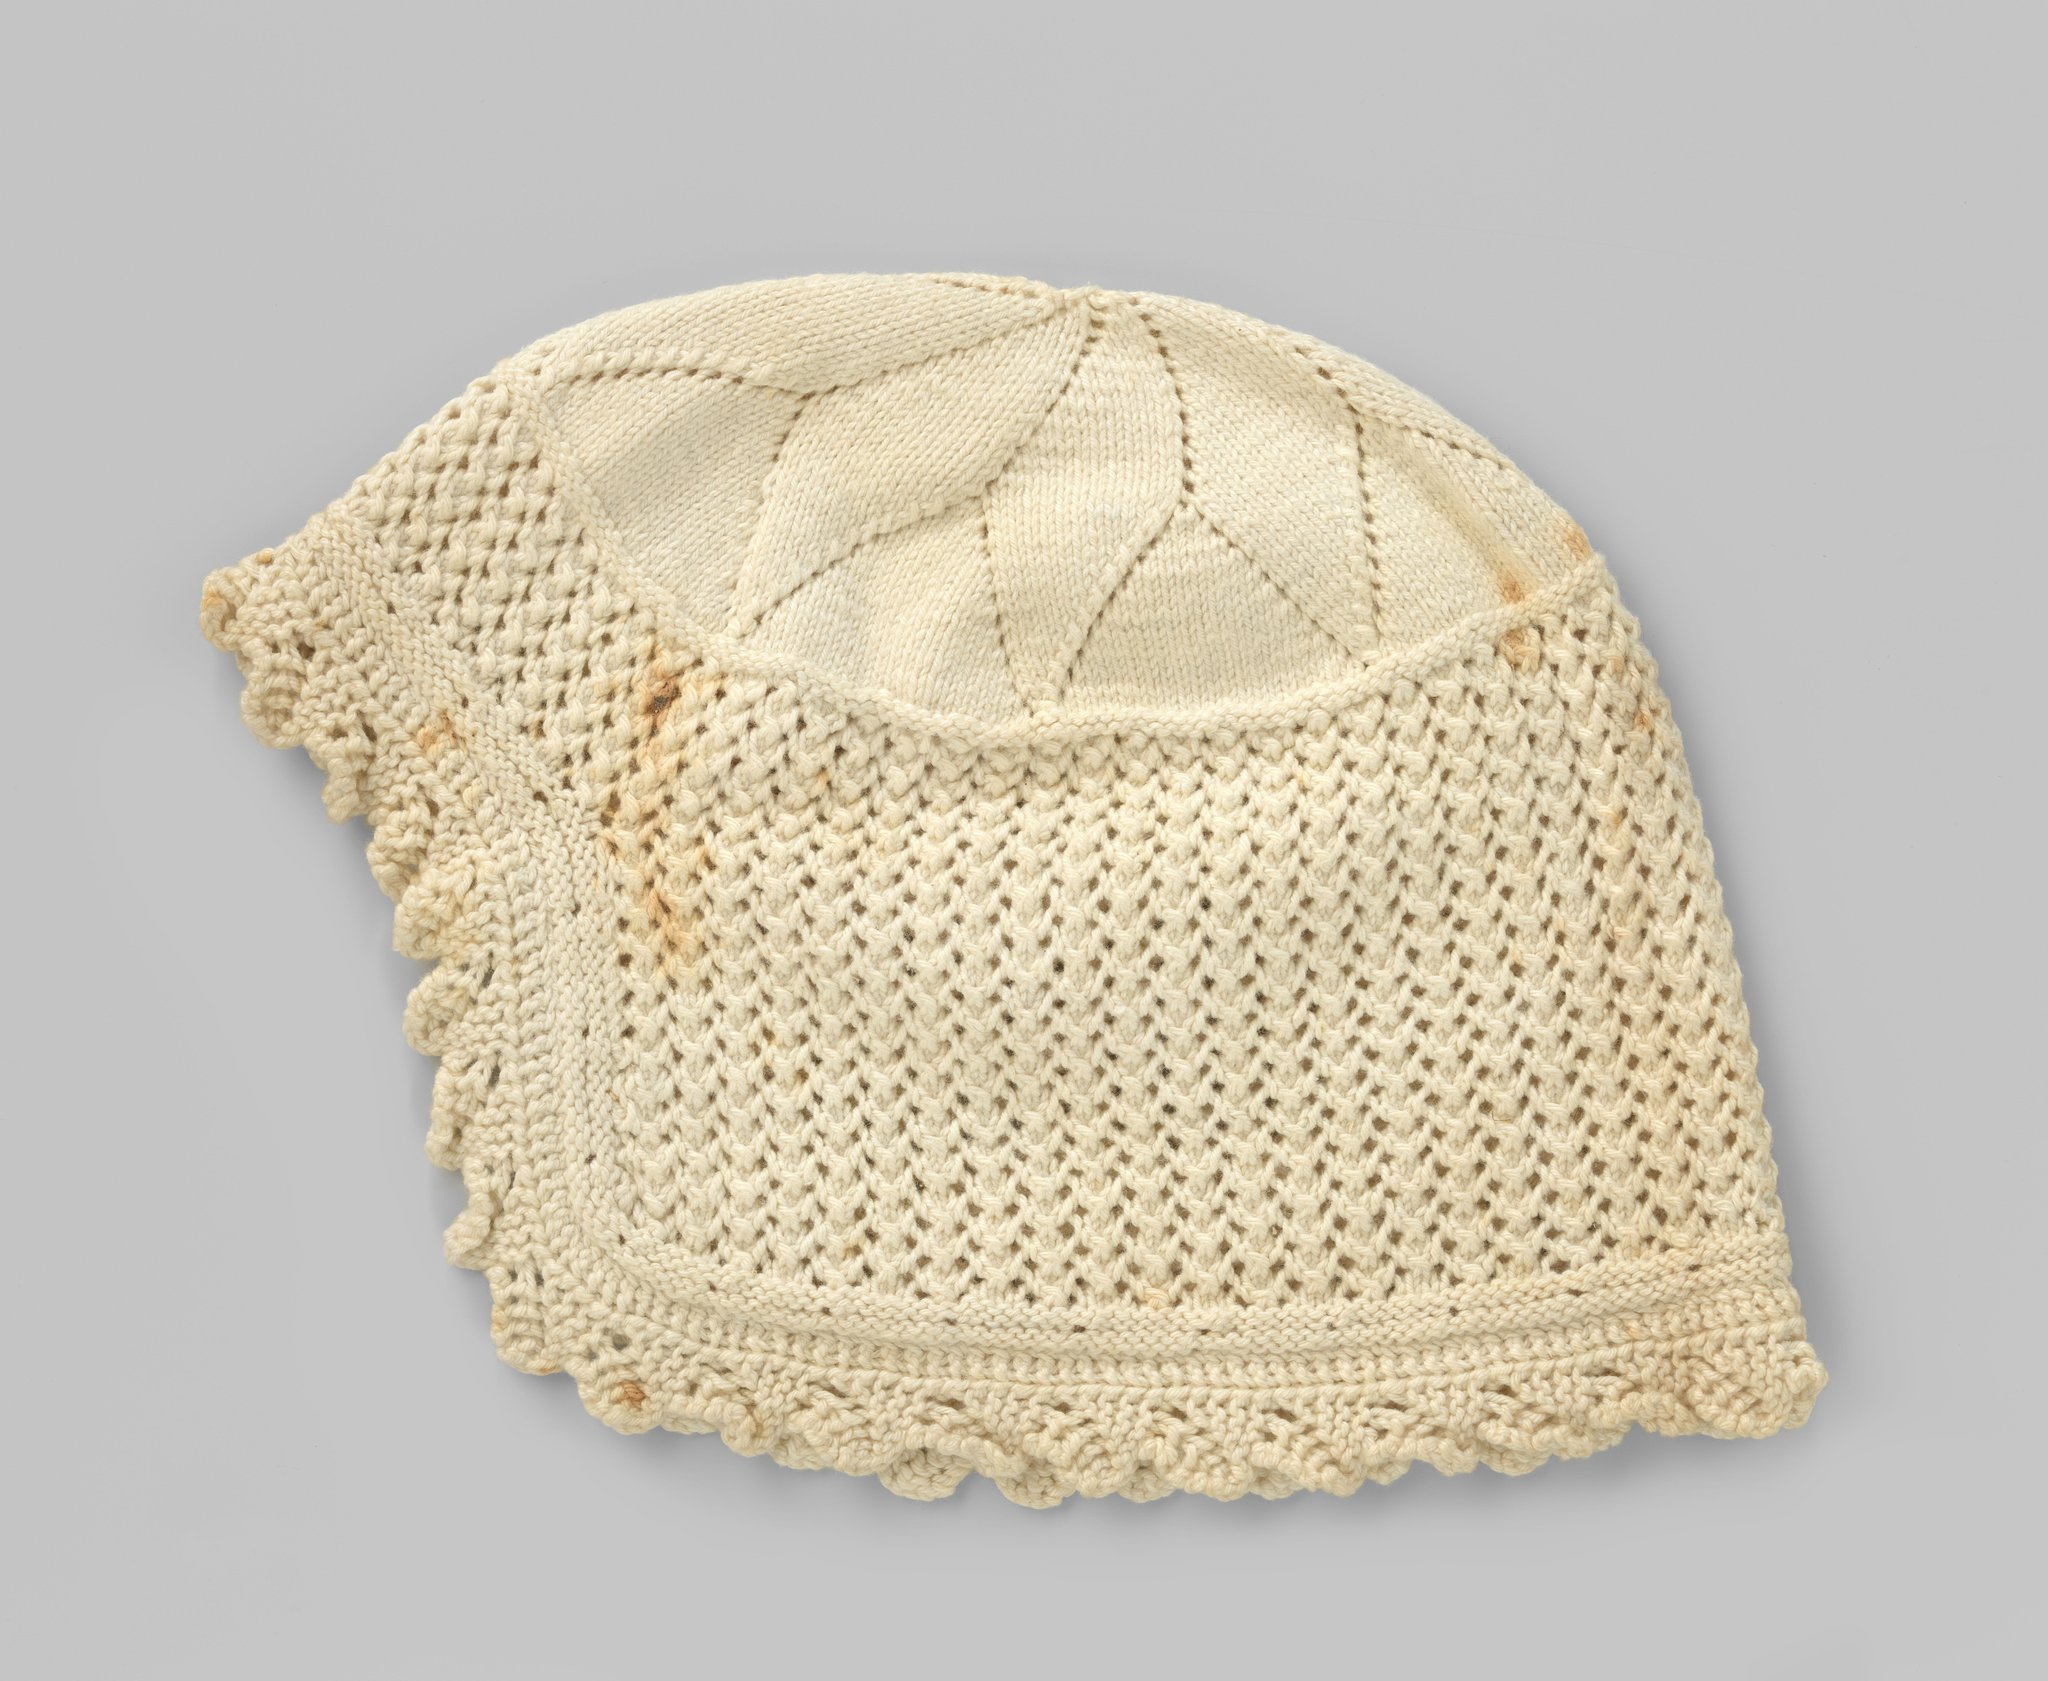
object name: cap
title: Gebreide kindermuts van wit katoen (?), met ajoursteek, geschulpte rand en bovenop een groot bloemmotief met een opening in het midden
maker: Anonymous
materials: cotton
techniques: embroidery, knitting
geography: europe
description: Gebreide kindermuts van wit katoen (?), met ajoursteek, geschulpte rand en bovenop een groot bloemmotief met een opening in het midden.